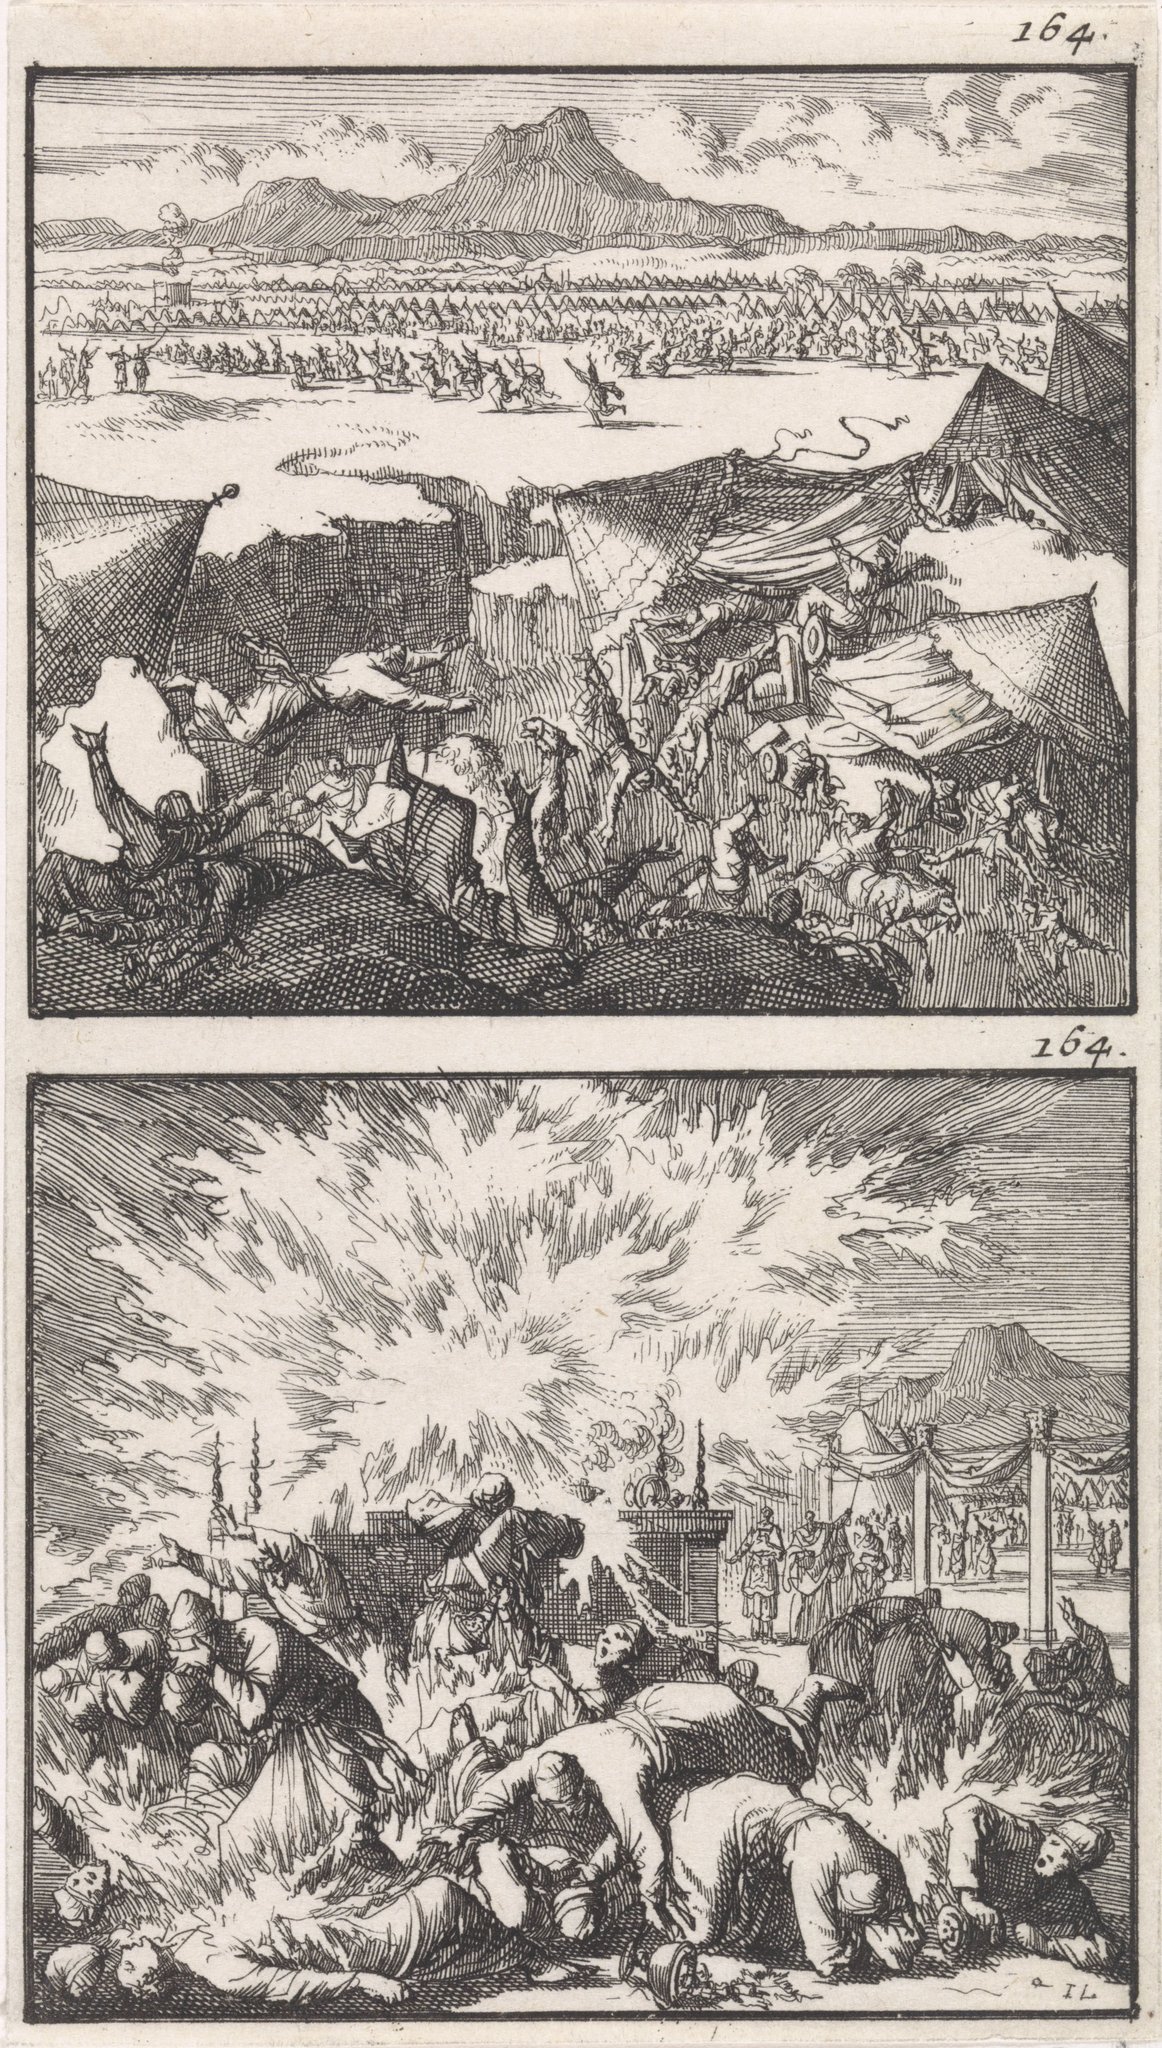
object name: book illustration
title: Datan en Abiram met hun gezinnen door de aarde verzwolgen / Vernietiging van de stam van Korach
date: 1698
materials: paper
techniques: etching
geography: amsterdam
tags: the ground opens and swallows the rebels dathan and abiram along with their families and possessions, rebellion of korah (core), dathan and abiram, and their punishment (numbers 16)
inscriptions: collector's mark: Lugt 2228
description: Illustratie uit: Josephus, Flavius. XX. boeken van de oude geschiedenissen der joden, 4 delen. Amsterdam: Barent Visscher, Willem de Coup, Willem van Lamsveld, Andries van Damme, 1698, dl. I.